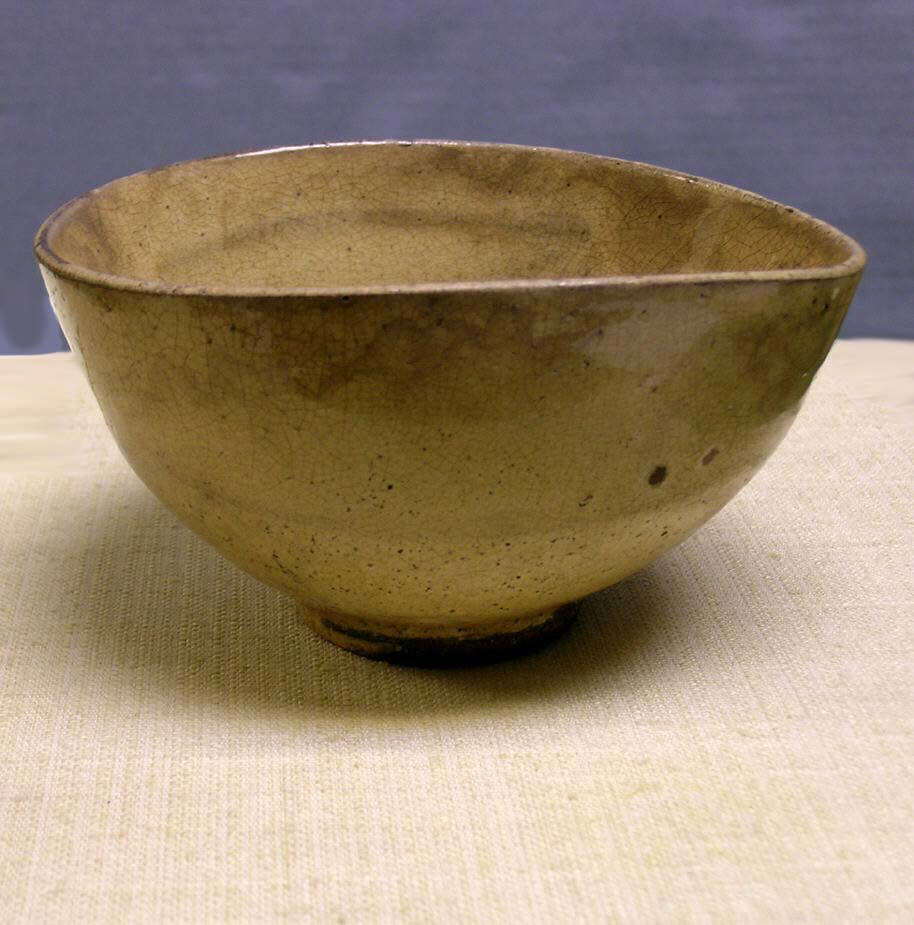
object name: bowl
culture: japanese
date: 1701-1800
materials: clay, glaze